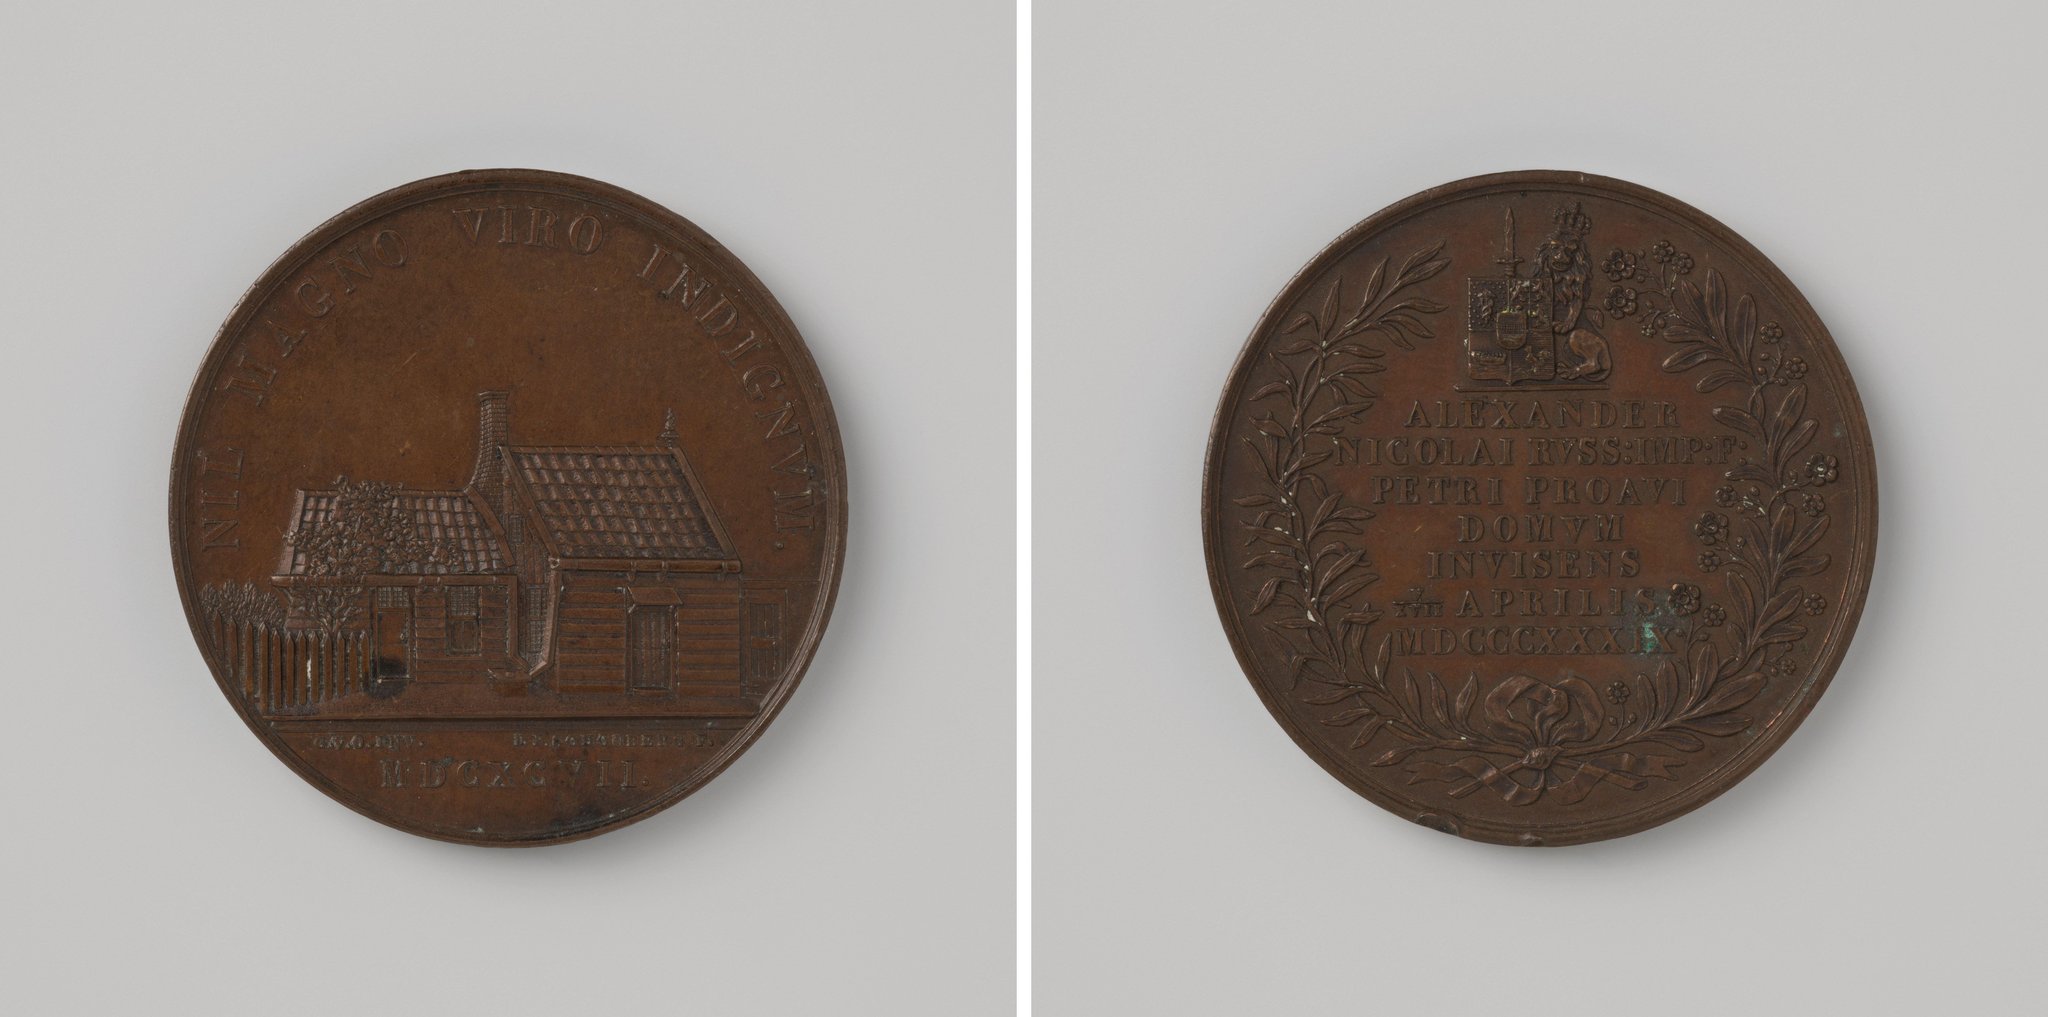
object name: history medal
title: De Russische troonopvolger bezoekt Zaandam en het Tsaar Peter-huis 1839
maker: johannis petrus schouberg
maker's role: die cutter, draughtsman, print maker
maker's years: 1798-1864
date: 1839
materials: bronze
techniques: striking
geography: utrecht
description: Bronzen penning, op de voorzijde het Tsaar Peterhuis met omschrift en afsnedetekst, op de keerzijde zeven regels tekst, onder een klein wapenschild gedragen door een gekroonde leeuw met zwaard, tussen een samengestrikte wilgen- en vergeetmijnietjestak.